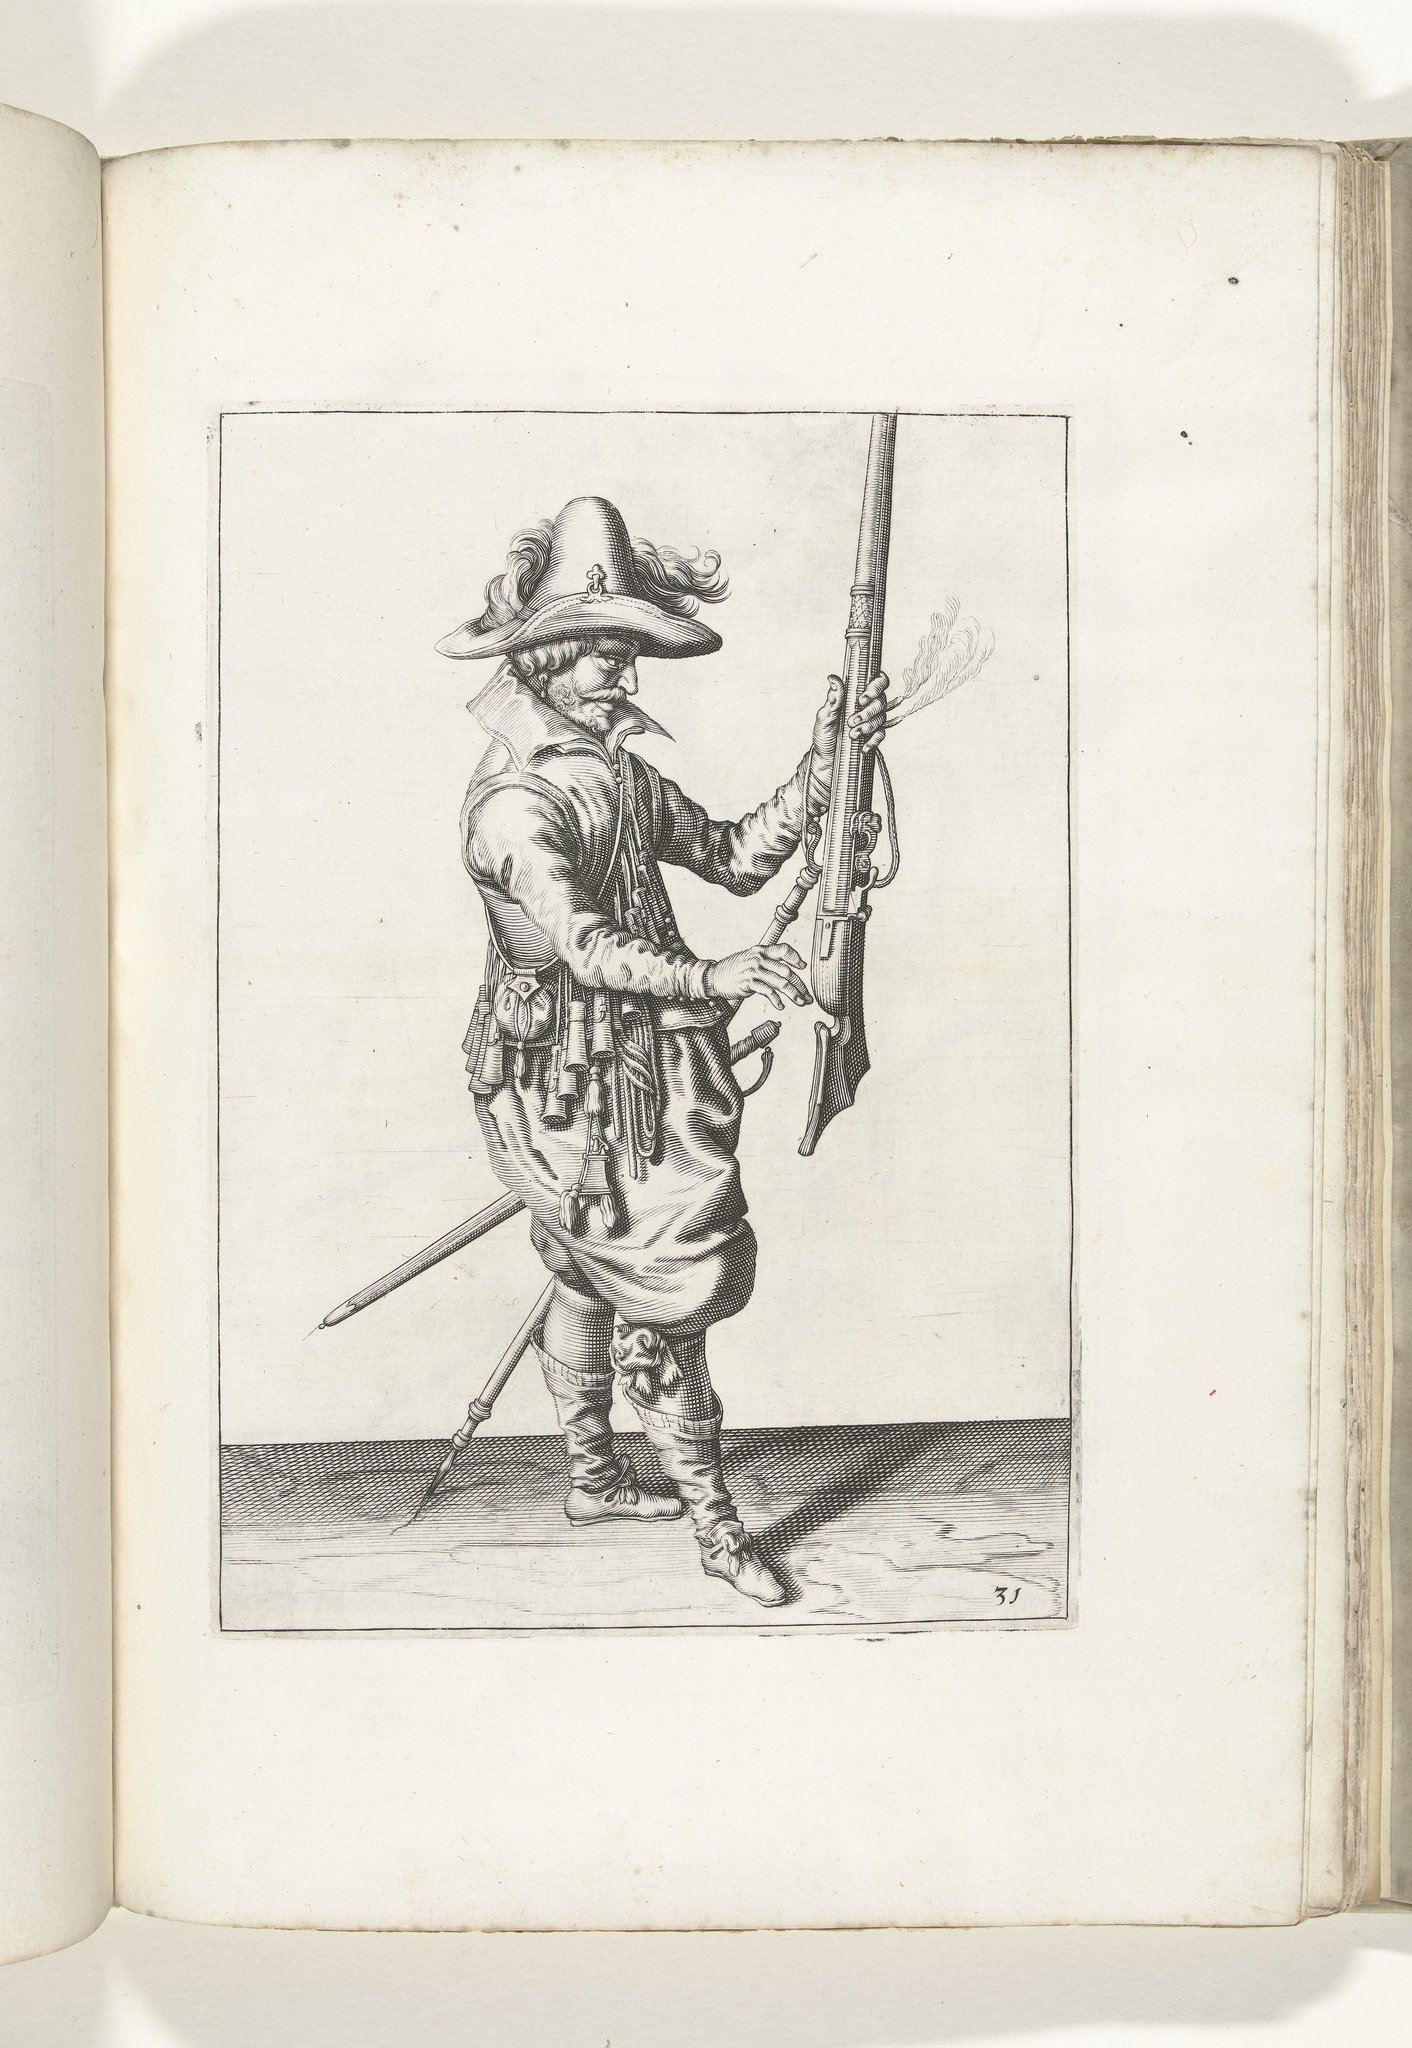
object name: print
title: Soldaat die zijn musket met zijn linkerhand rechtop vasthoudt (nr. 31), ca. 1600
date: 1597-1607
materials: paper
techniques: engraving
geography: northern netherlands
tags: the hague, maurice (prince of orange), handling of weapons ~ military training, weapons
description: Een soldaat, ten voeten uit, naar rechts, die een musket (een bepaald type vuurwapen) met zijn linkerhand vasthoudt, de loop omhoog wijzend, alvorens het wapen over te brengen naar zijn rechterhand (nr. 31), ca. 1600. In zijn linkerhand behalve het musket ook een brandende lont; aan zijn linkerpols een furket (musketvork). Plaat 31 in de instructies voor het hanteren van het musket: Corte onderrechtinghe op de figuerliicke afbeeldinghe, soo veel aengaet het recht ghebruyck vant Musquet. Onderdeel van de illustraties in: J. de Gheyn, Wapenhandelinghe van Roers Musquetten ende spiessen, 's-Gravenhage, 1607. Krijgswezen rond 1600.